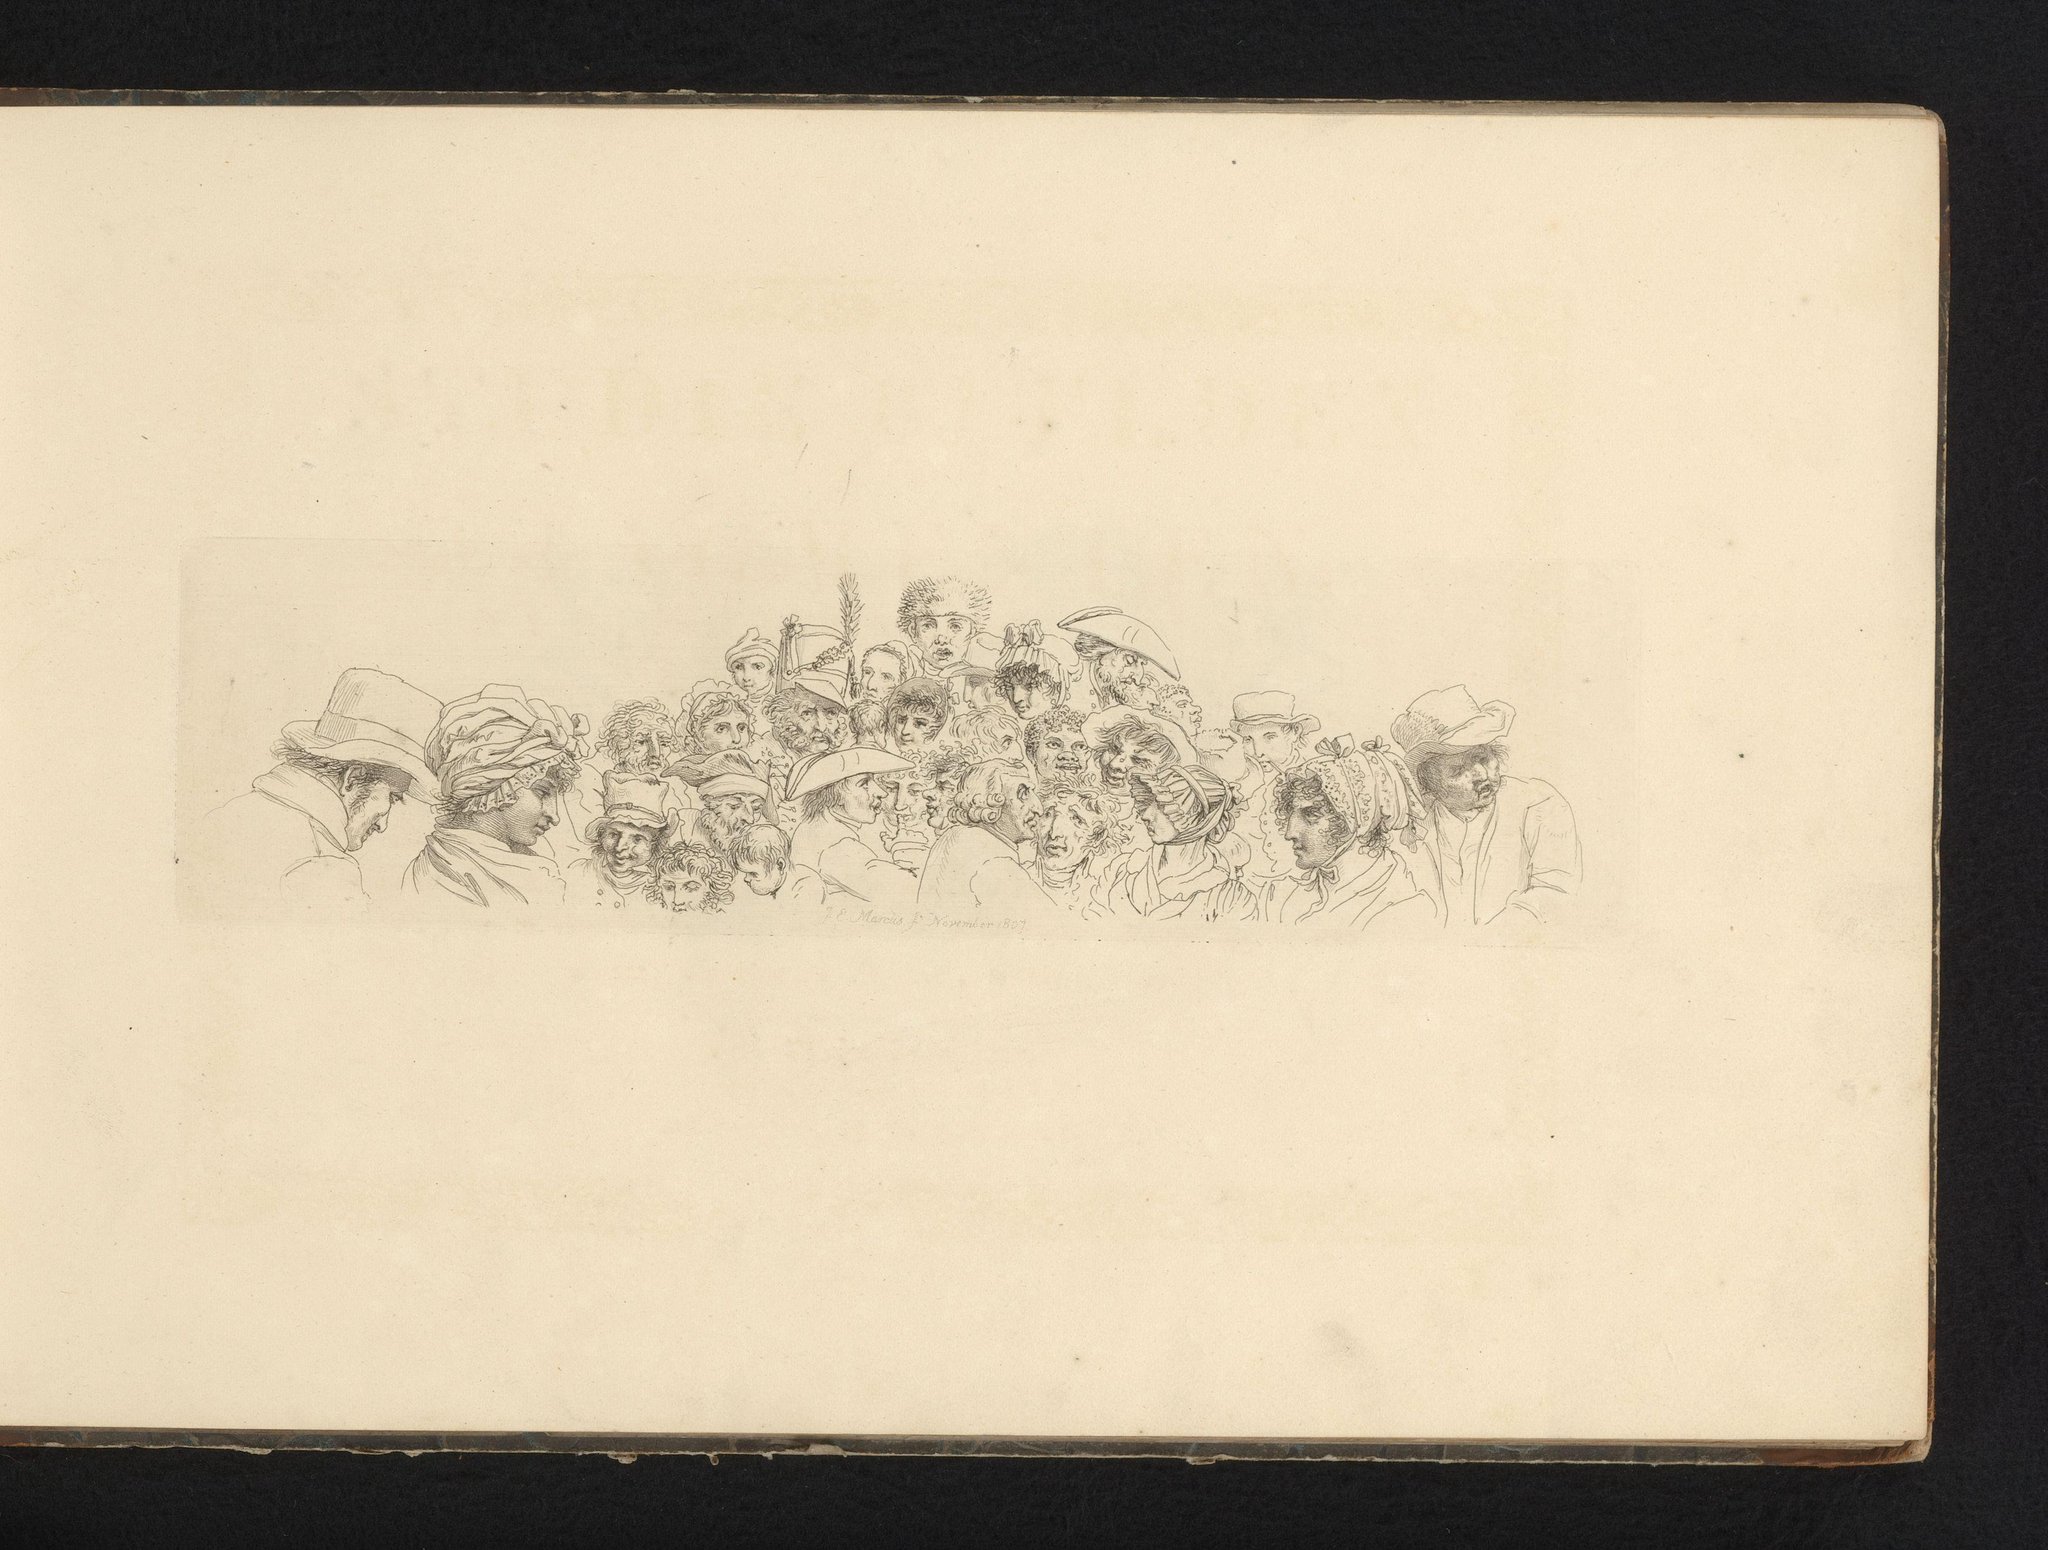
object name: print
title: Studiebeelden en fragmenten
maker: jacob ernst marcus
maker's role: draughtsman, print maker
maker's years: 1774-1826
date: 1807-1811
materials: paper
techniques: etching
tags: face, head-gear, soldiers and civilians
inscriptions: date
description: Deze prent maakt deel uit van een album.